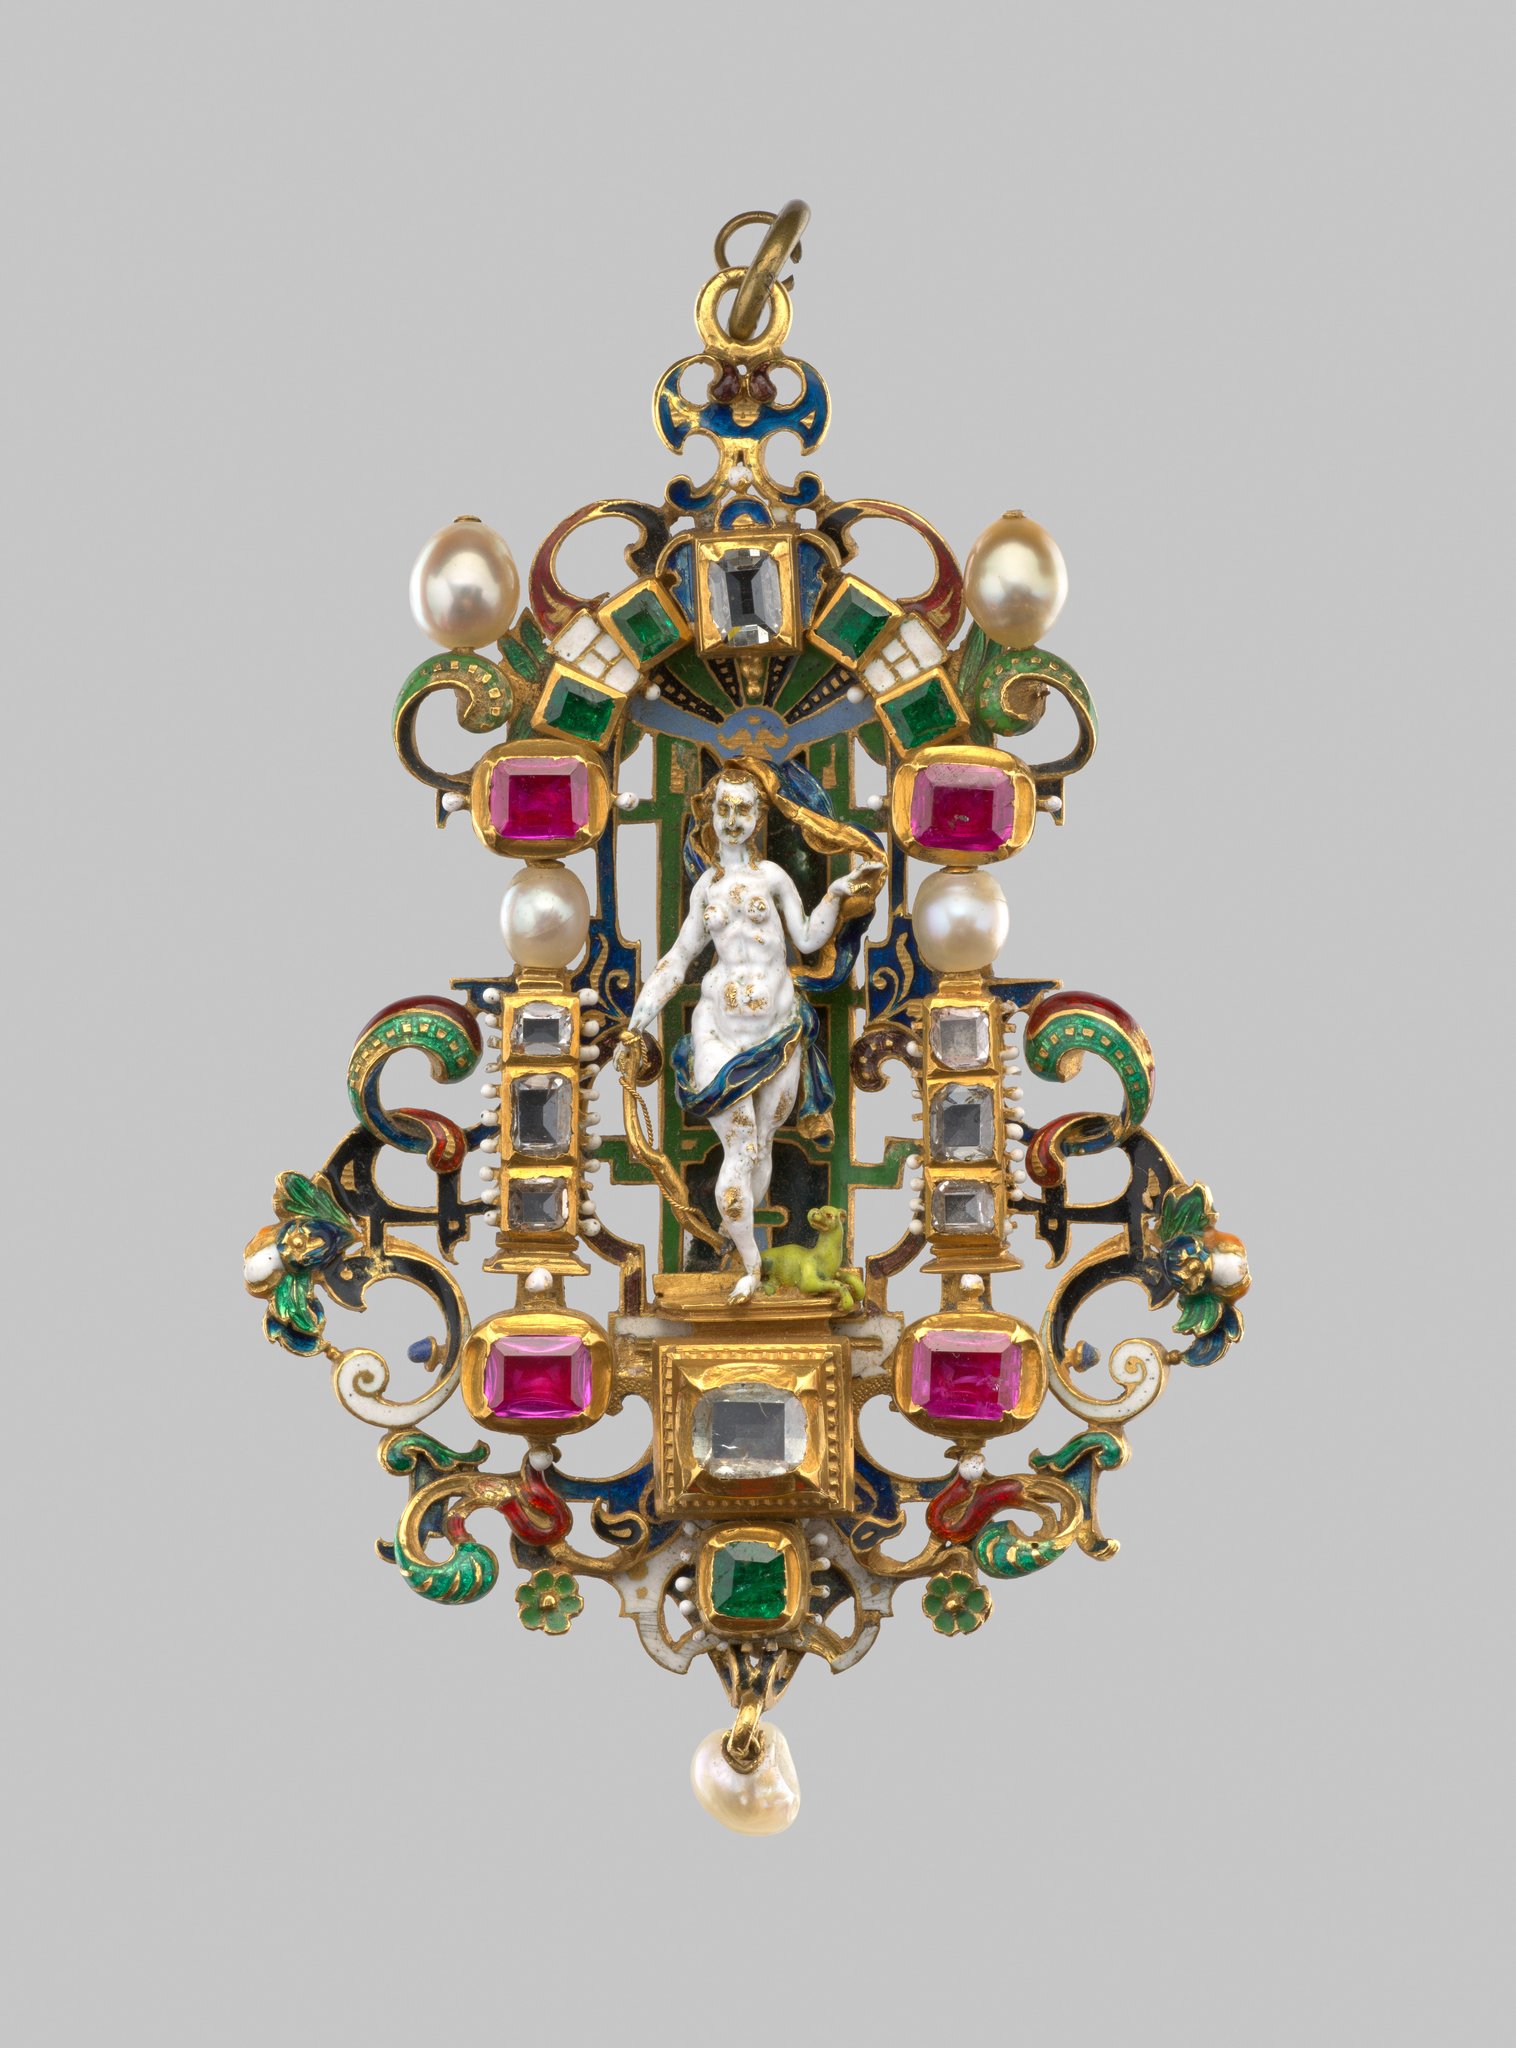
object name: pendant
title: Sixteenth-century-style pendant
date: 1801-1900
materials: diamond, gemstone, enamel, gold, pearl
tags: female nudes,diana,dogs